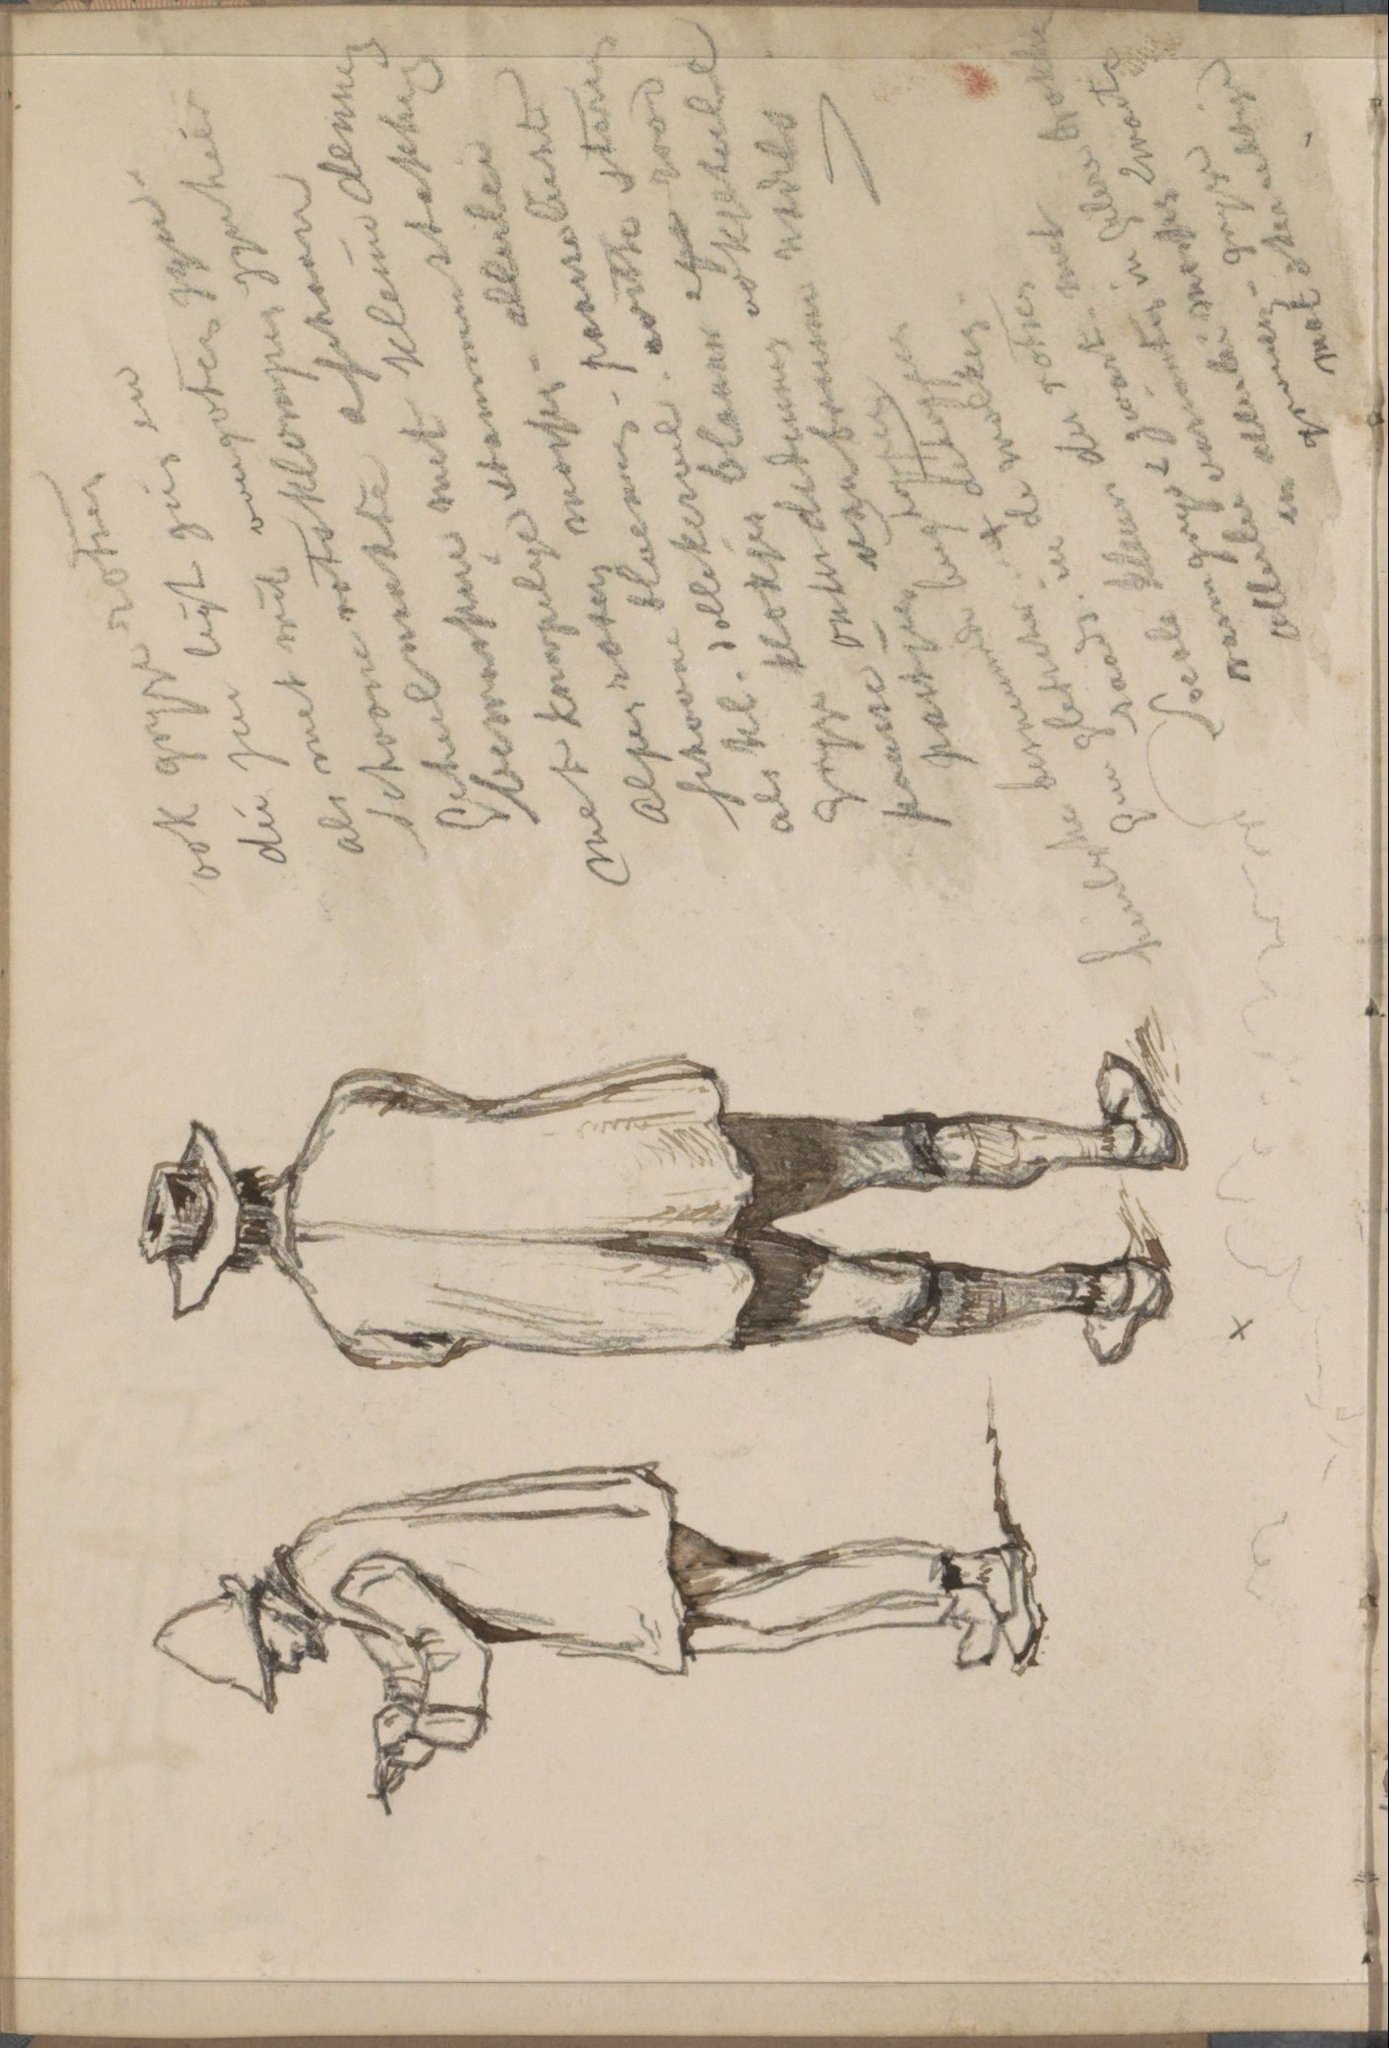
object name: sketchbook leaf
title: Twee mannen in Tiroler kostuum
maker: johannes tavenraat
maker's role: draughtsman, painter, print maker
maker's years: 1809-1881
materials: ink, paper, pencil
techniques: brush, pen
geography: tirol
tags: folk costume, regional costume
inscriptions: kleurnotitie, handgeschreven in potlood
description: Blad 6 verso uit een schetsboek met 47 bladen.